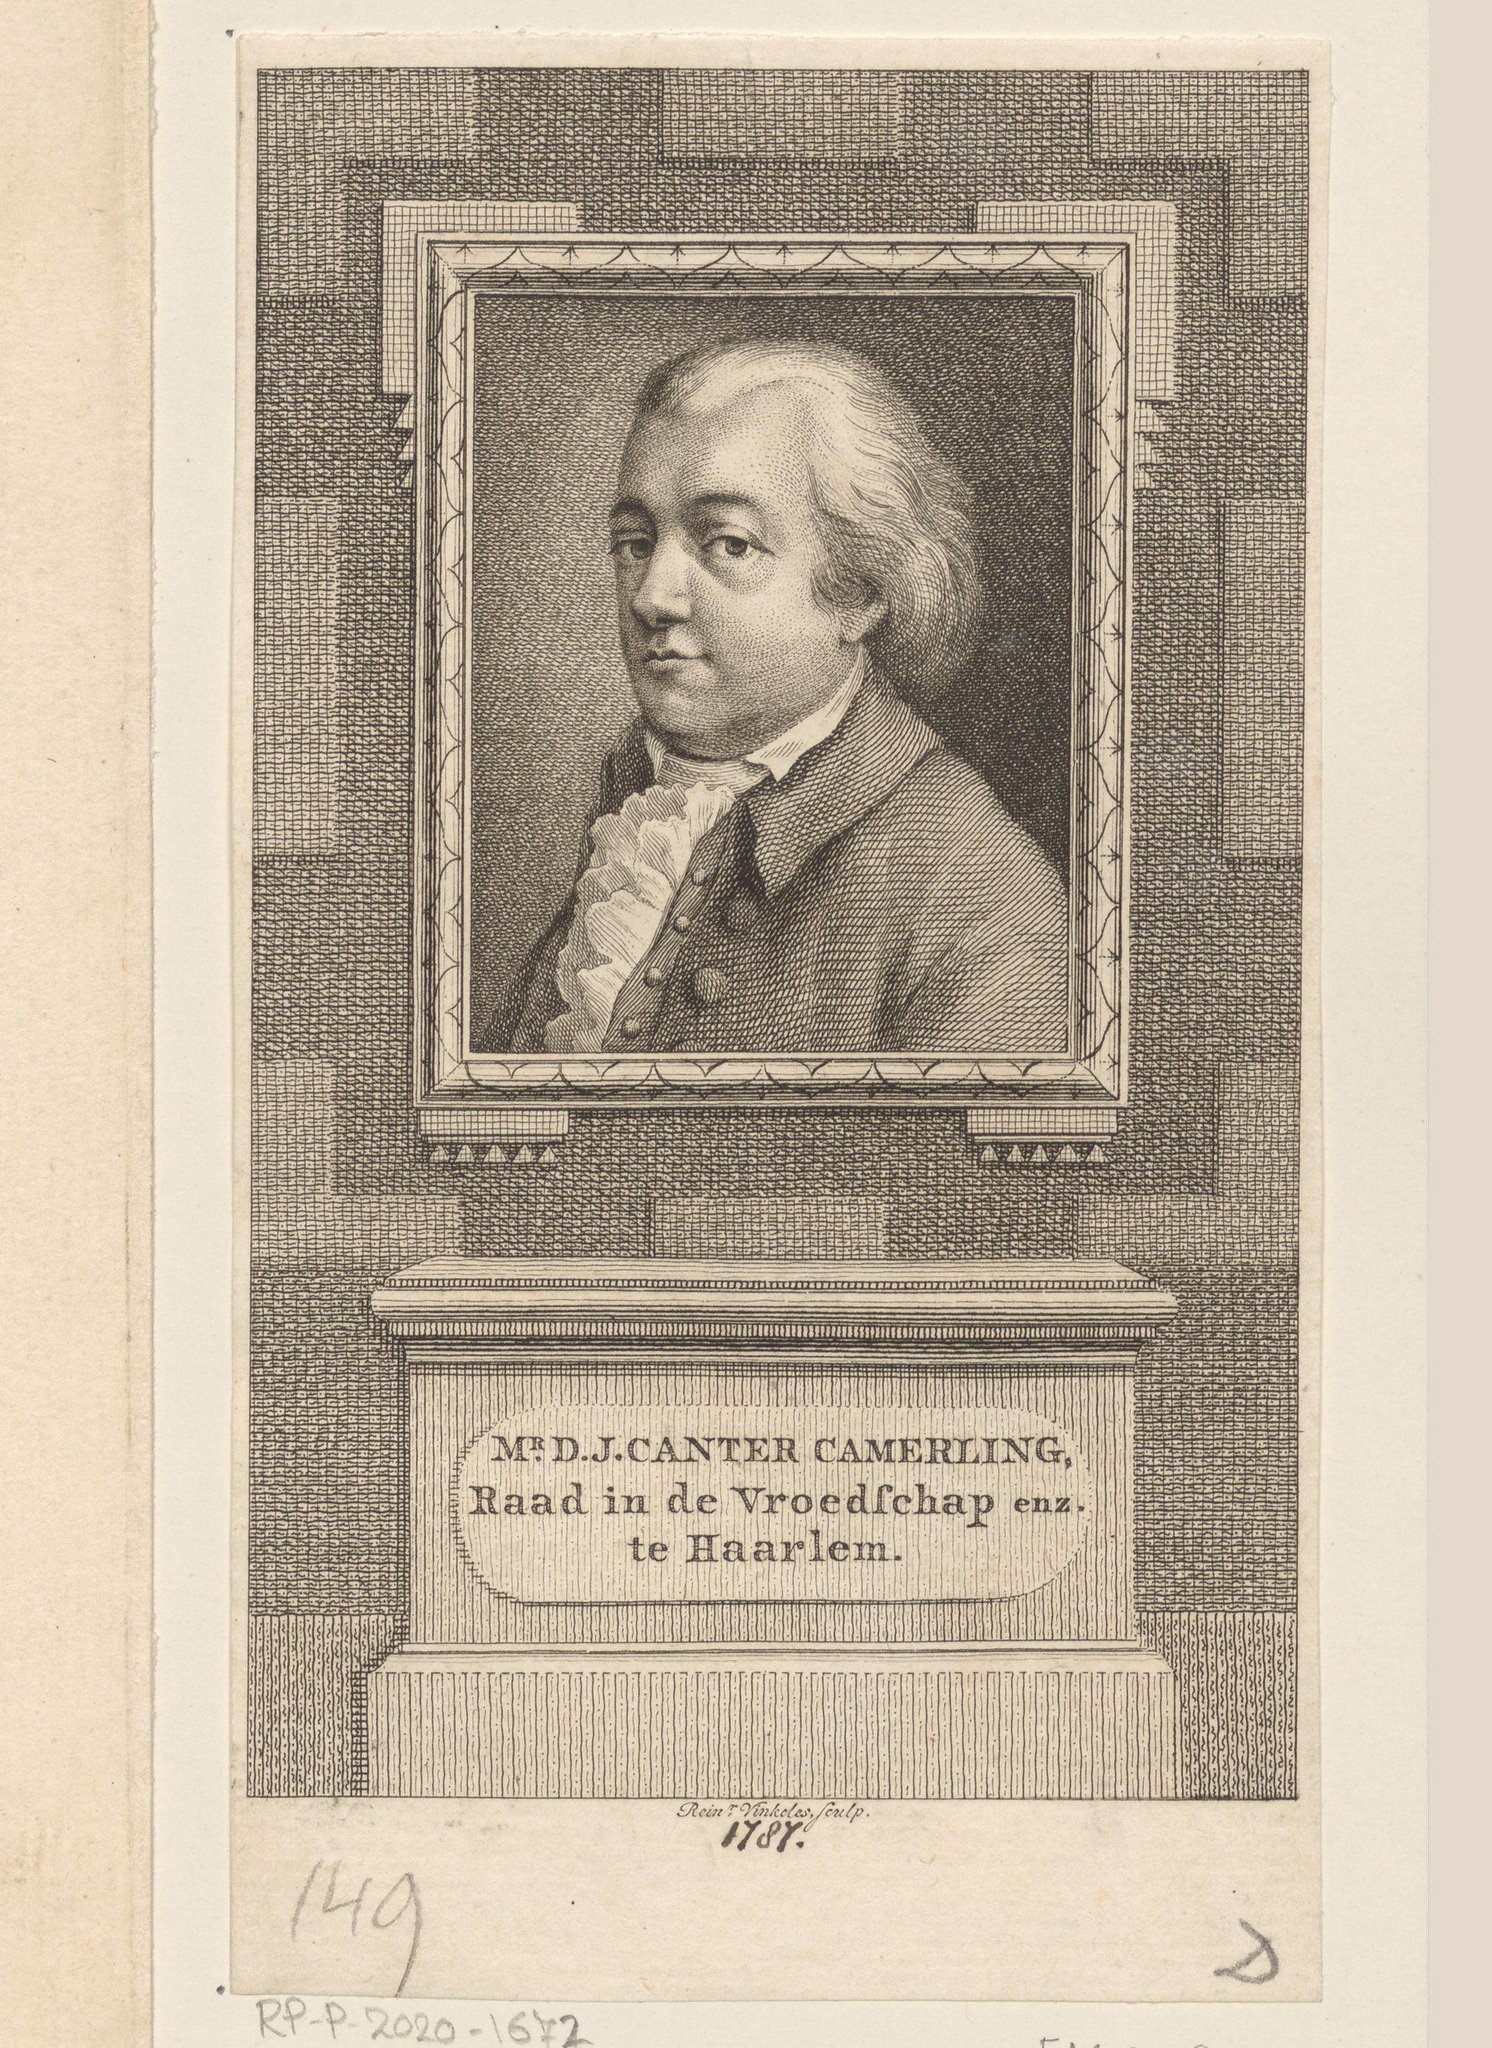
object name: print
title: Prent van Daniël Jacobus Canter Camerling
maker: reinier vinkeles (i)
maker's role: draughtsman, print maker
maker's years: 1741-1816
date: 1787-1816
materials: paper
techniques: engraving, etching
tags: haarlem, mayor, historical persons